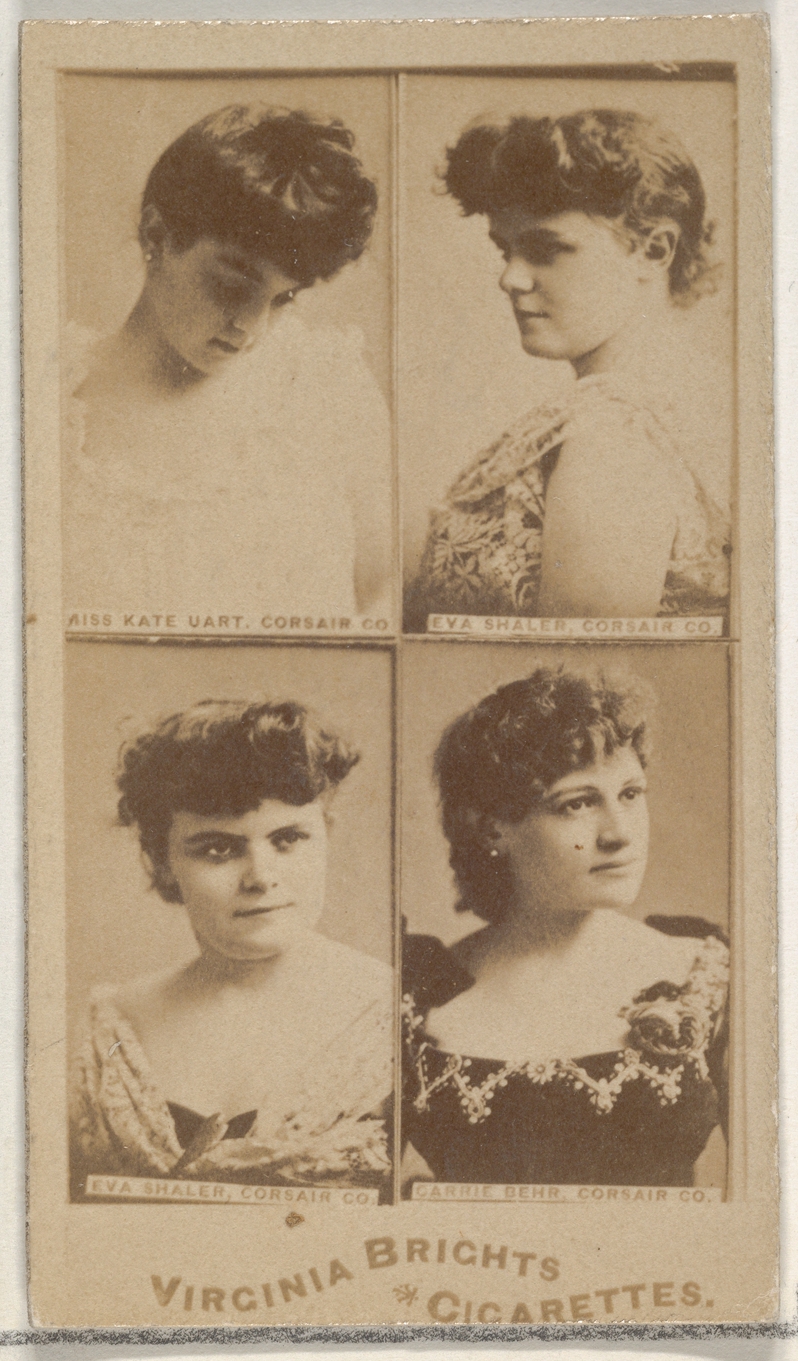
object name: photograph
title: Miss Kate Uart, Corsair Co./ Eva Shaler, Corsair Co./ Eva Shaler, Corsair Co./ Carrie Behr, Corsair Co., from the Actors and Actresses series (N45, Type 4) for Virginia Brights Cigarettes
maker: allen & ginter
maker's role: publisher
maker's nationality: american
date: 1888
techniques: albumen silver print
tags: portraits,women,actresses